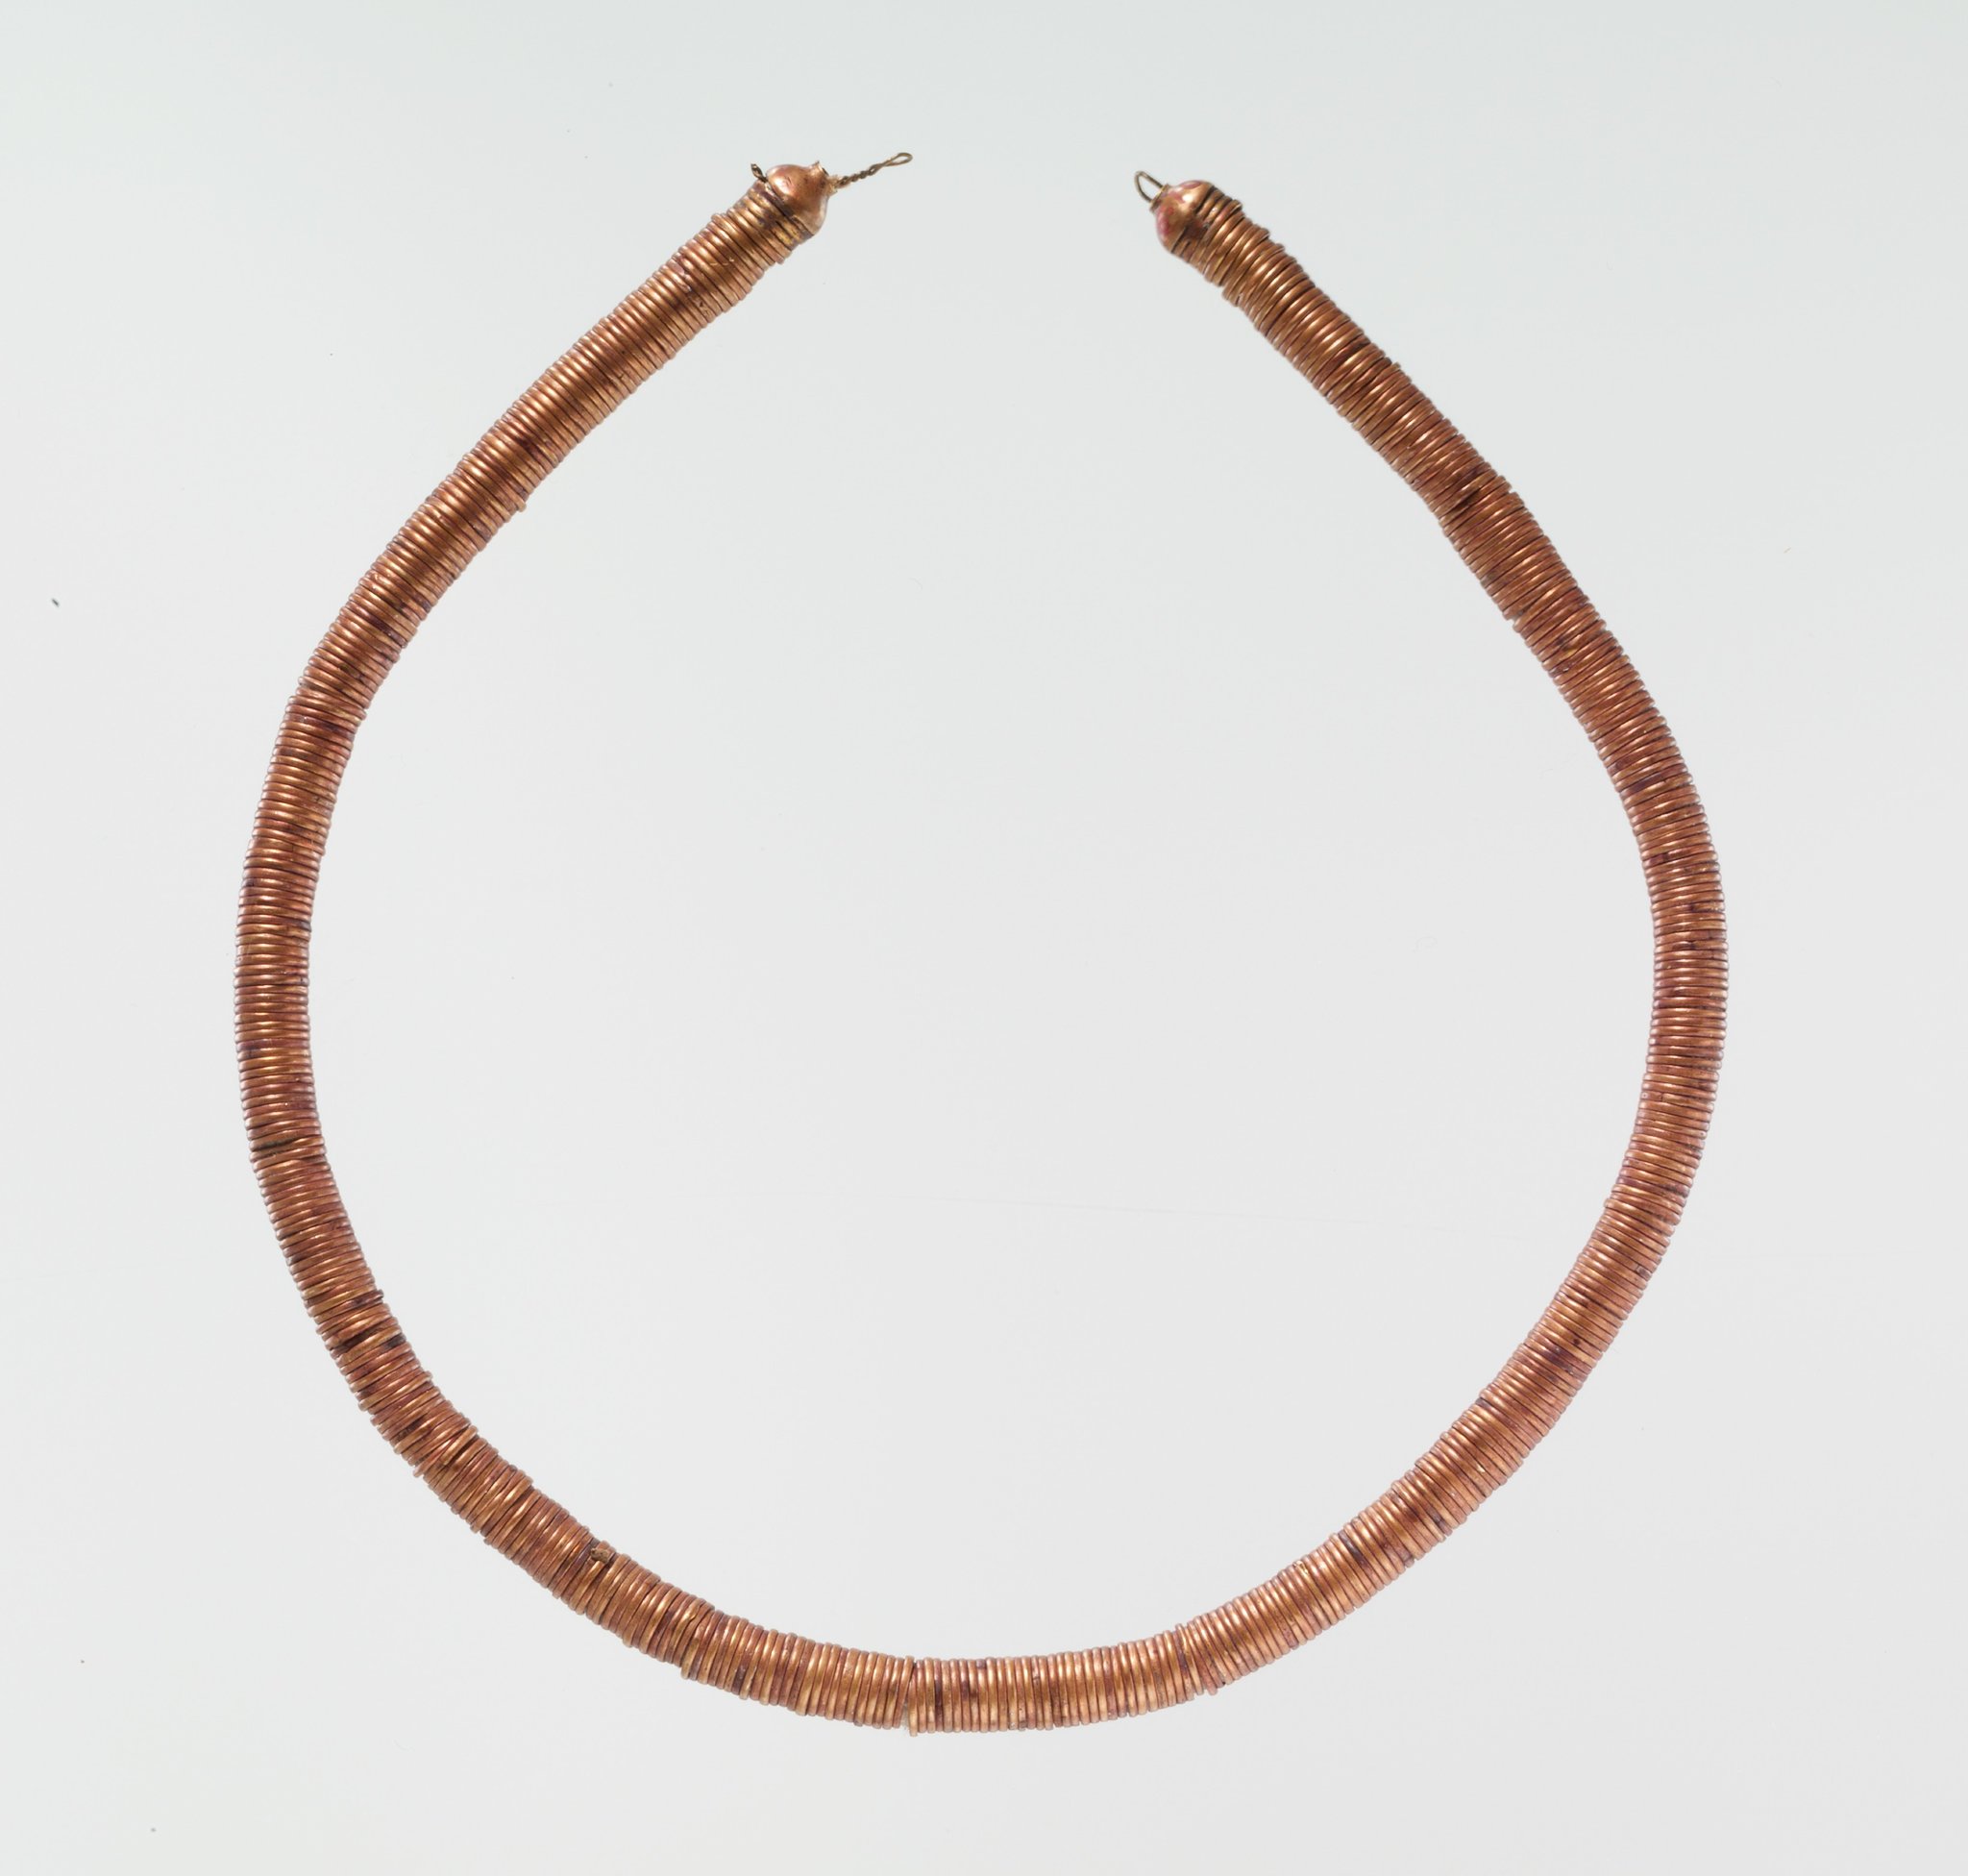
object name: necklace, choker, ring bead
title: Choker of Gold Rings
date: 1635-1458 BCE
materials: gold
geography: egypt